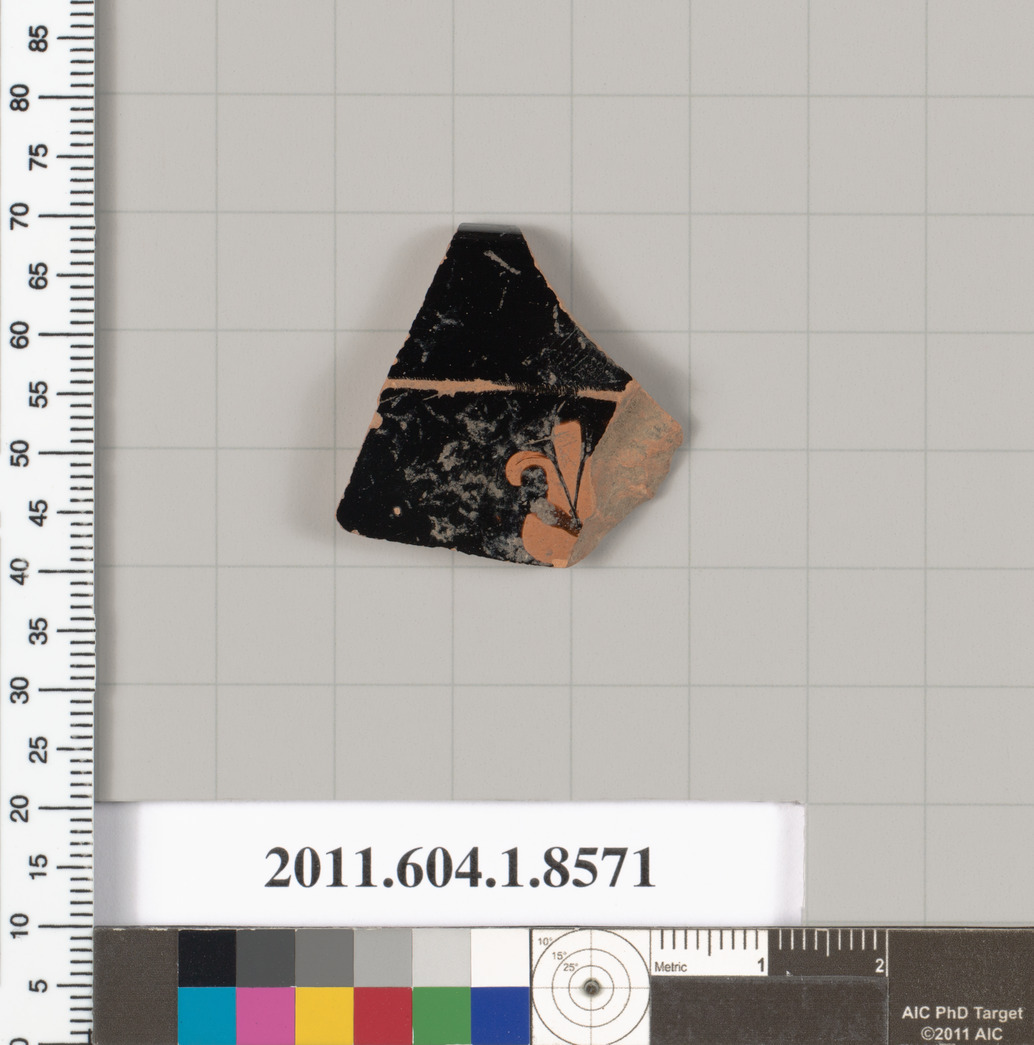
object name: kylix fragment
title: Terracotta rim fragment of a stemless kylix (drinking cup)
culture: greek, attic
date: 460-450 BCE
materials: terracotta